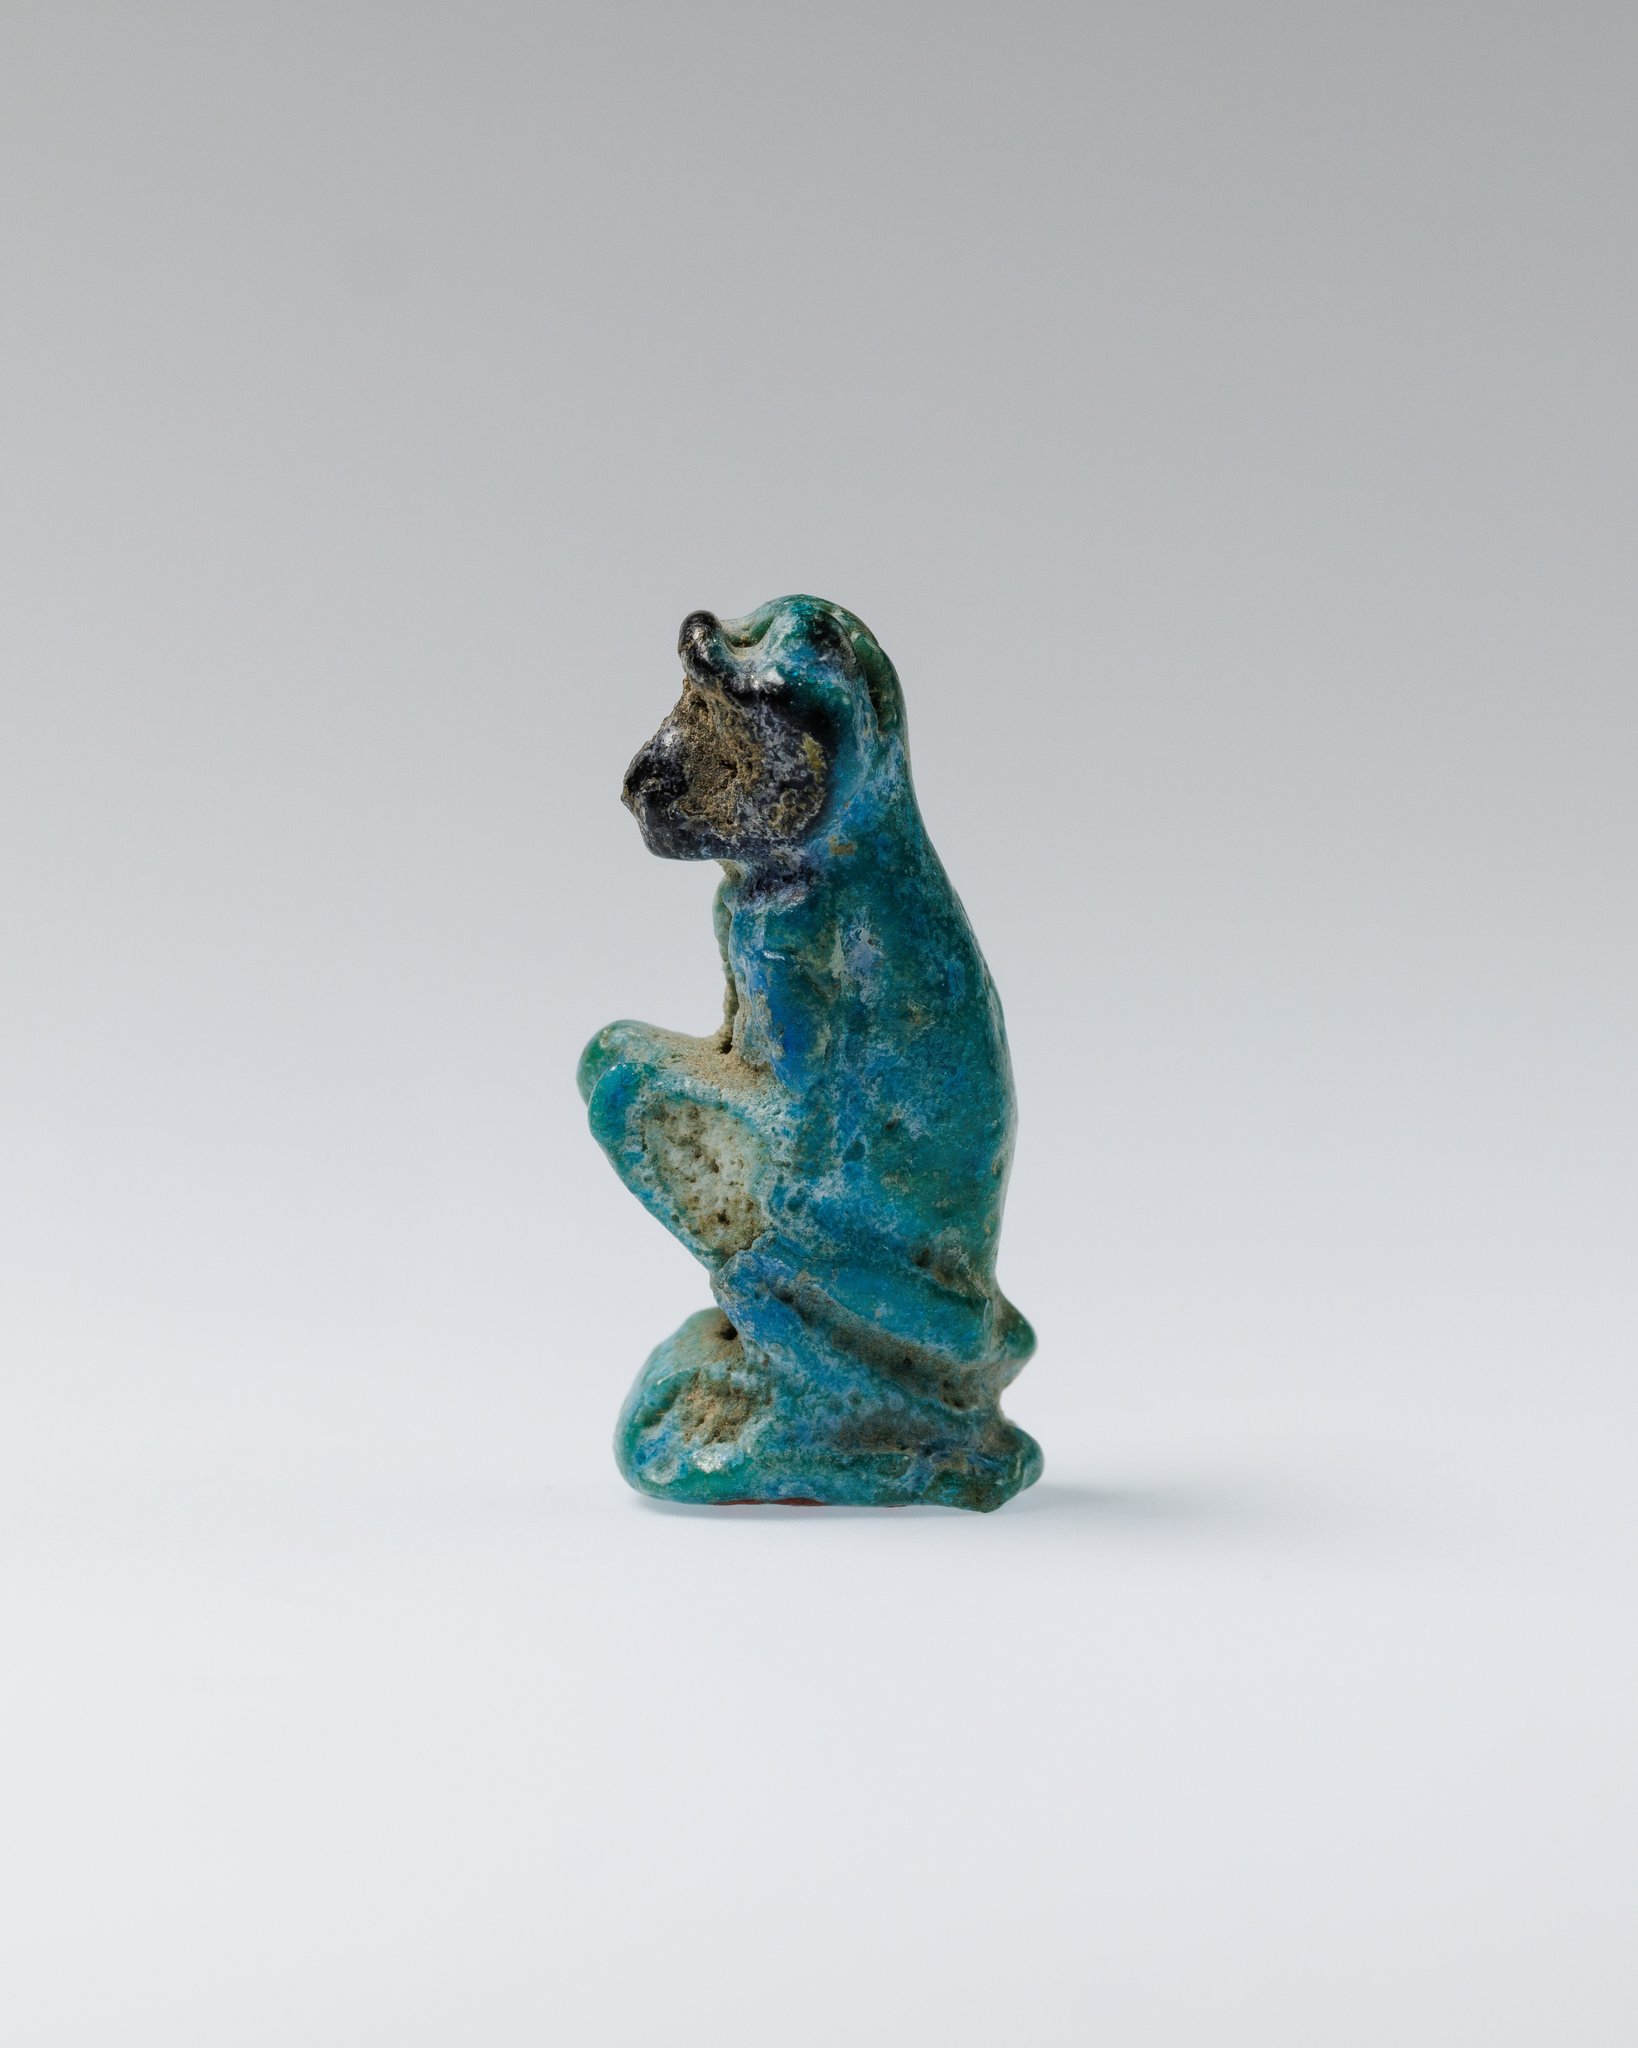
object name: amulet, monkey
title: Amulet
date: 1295-1070 BCE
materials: faience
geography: egypt